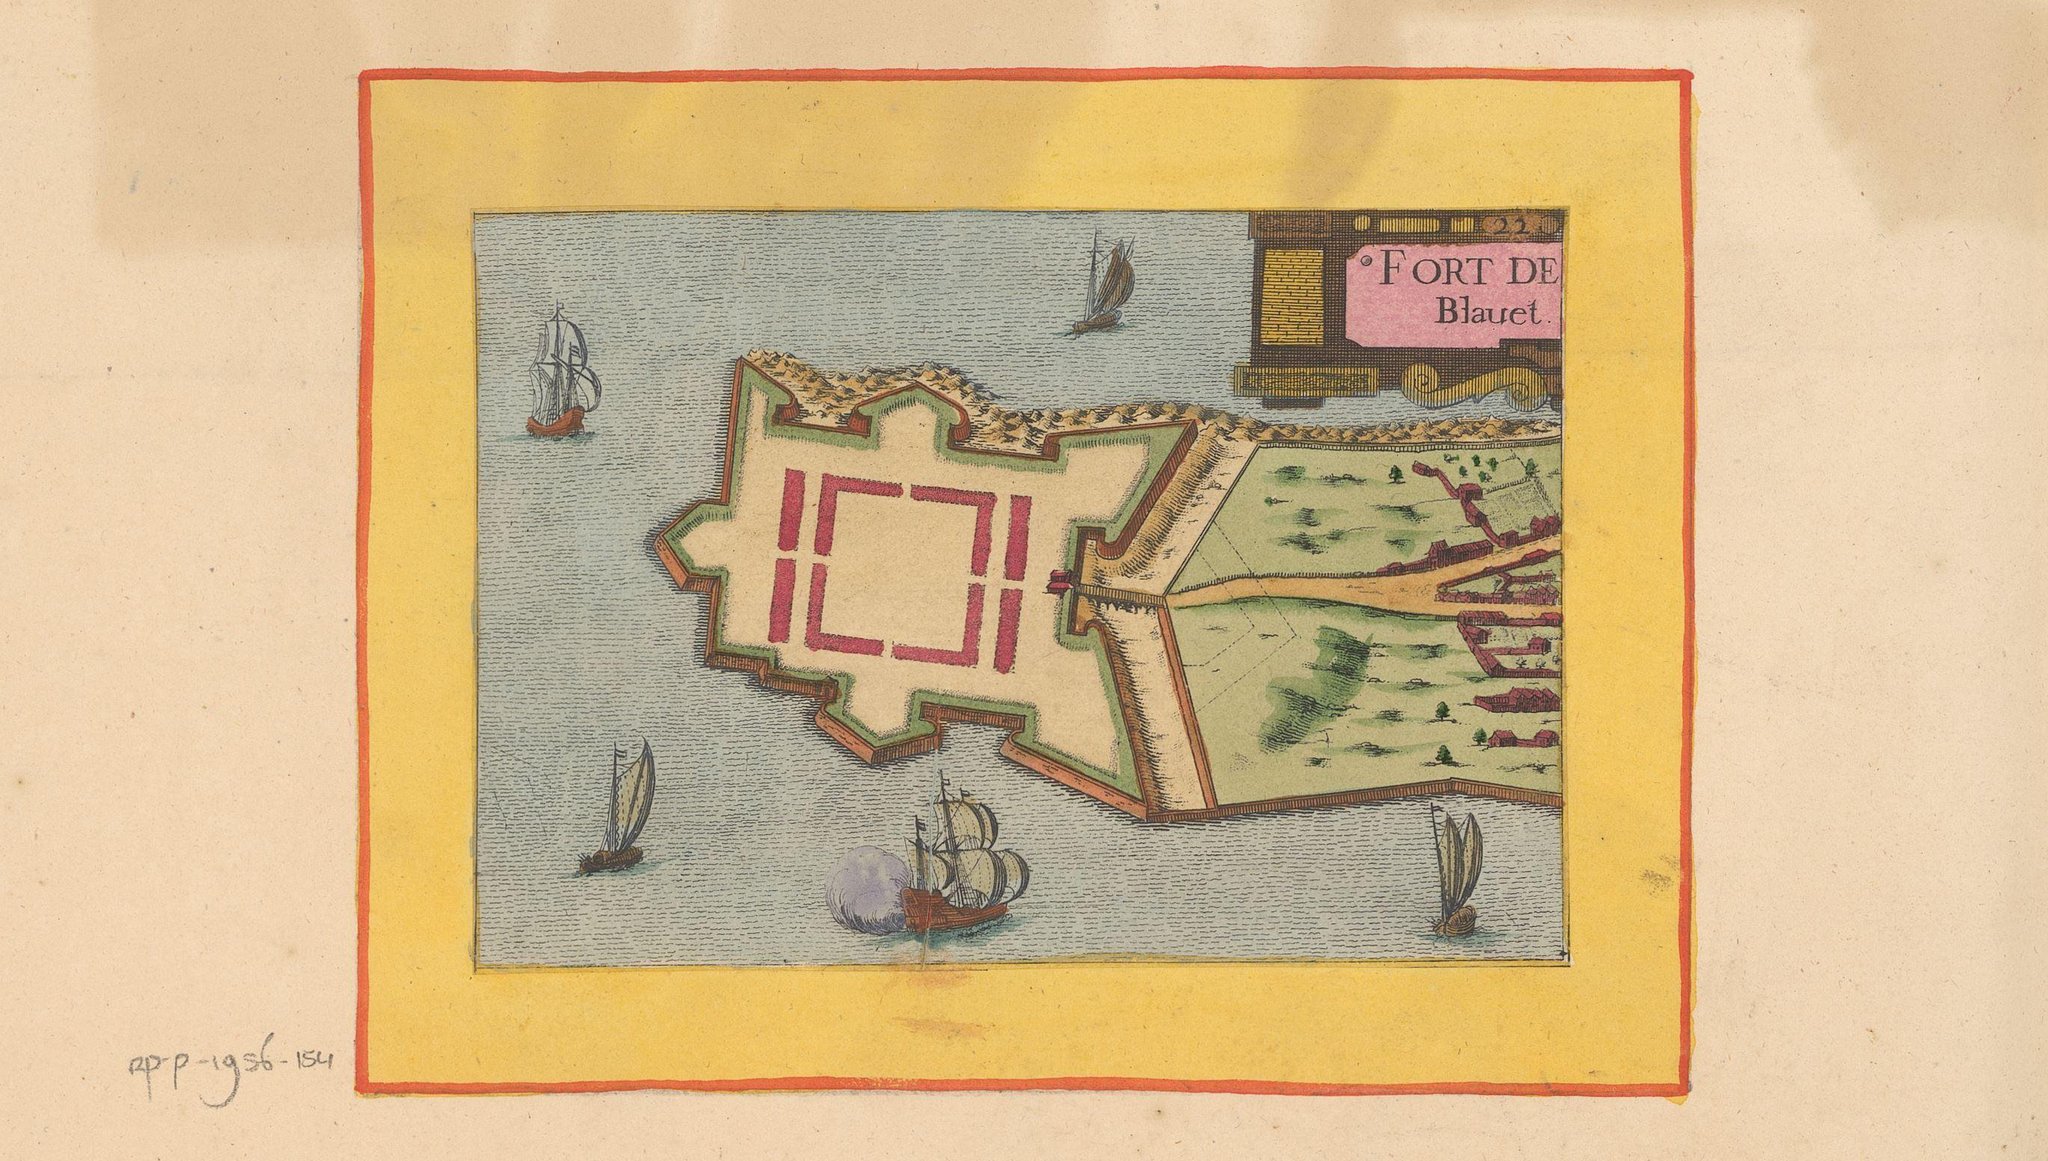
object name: area plan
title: Plattegrond van de citadel bij Port-Louis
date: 1638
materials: paper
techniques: engraving, etching, hand coloring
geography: the hague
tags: maps of cities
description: Prent uit: Tassin, Christophe. Les plans et profils de toutes les principales villes et lieux considérables de France (...). Parijs: Michel van Lochom, 1638, prent nummer 22 in het deel 'Bretaigne'.